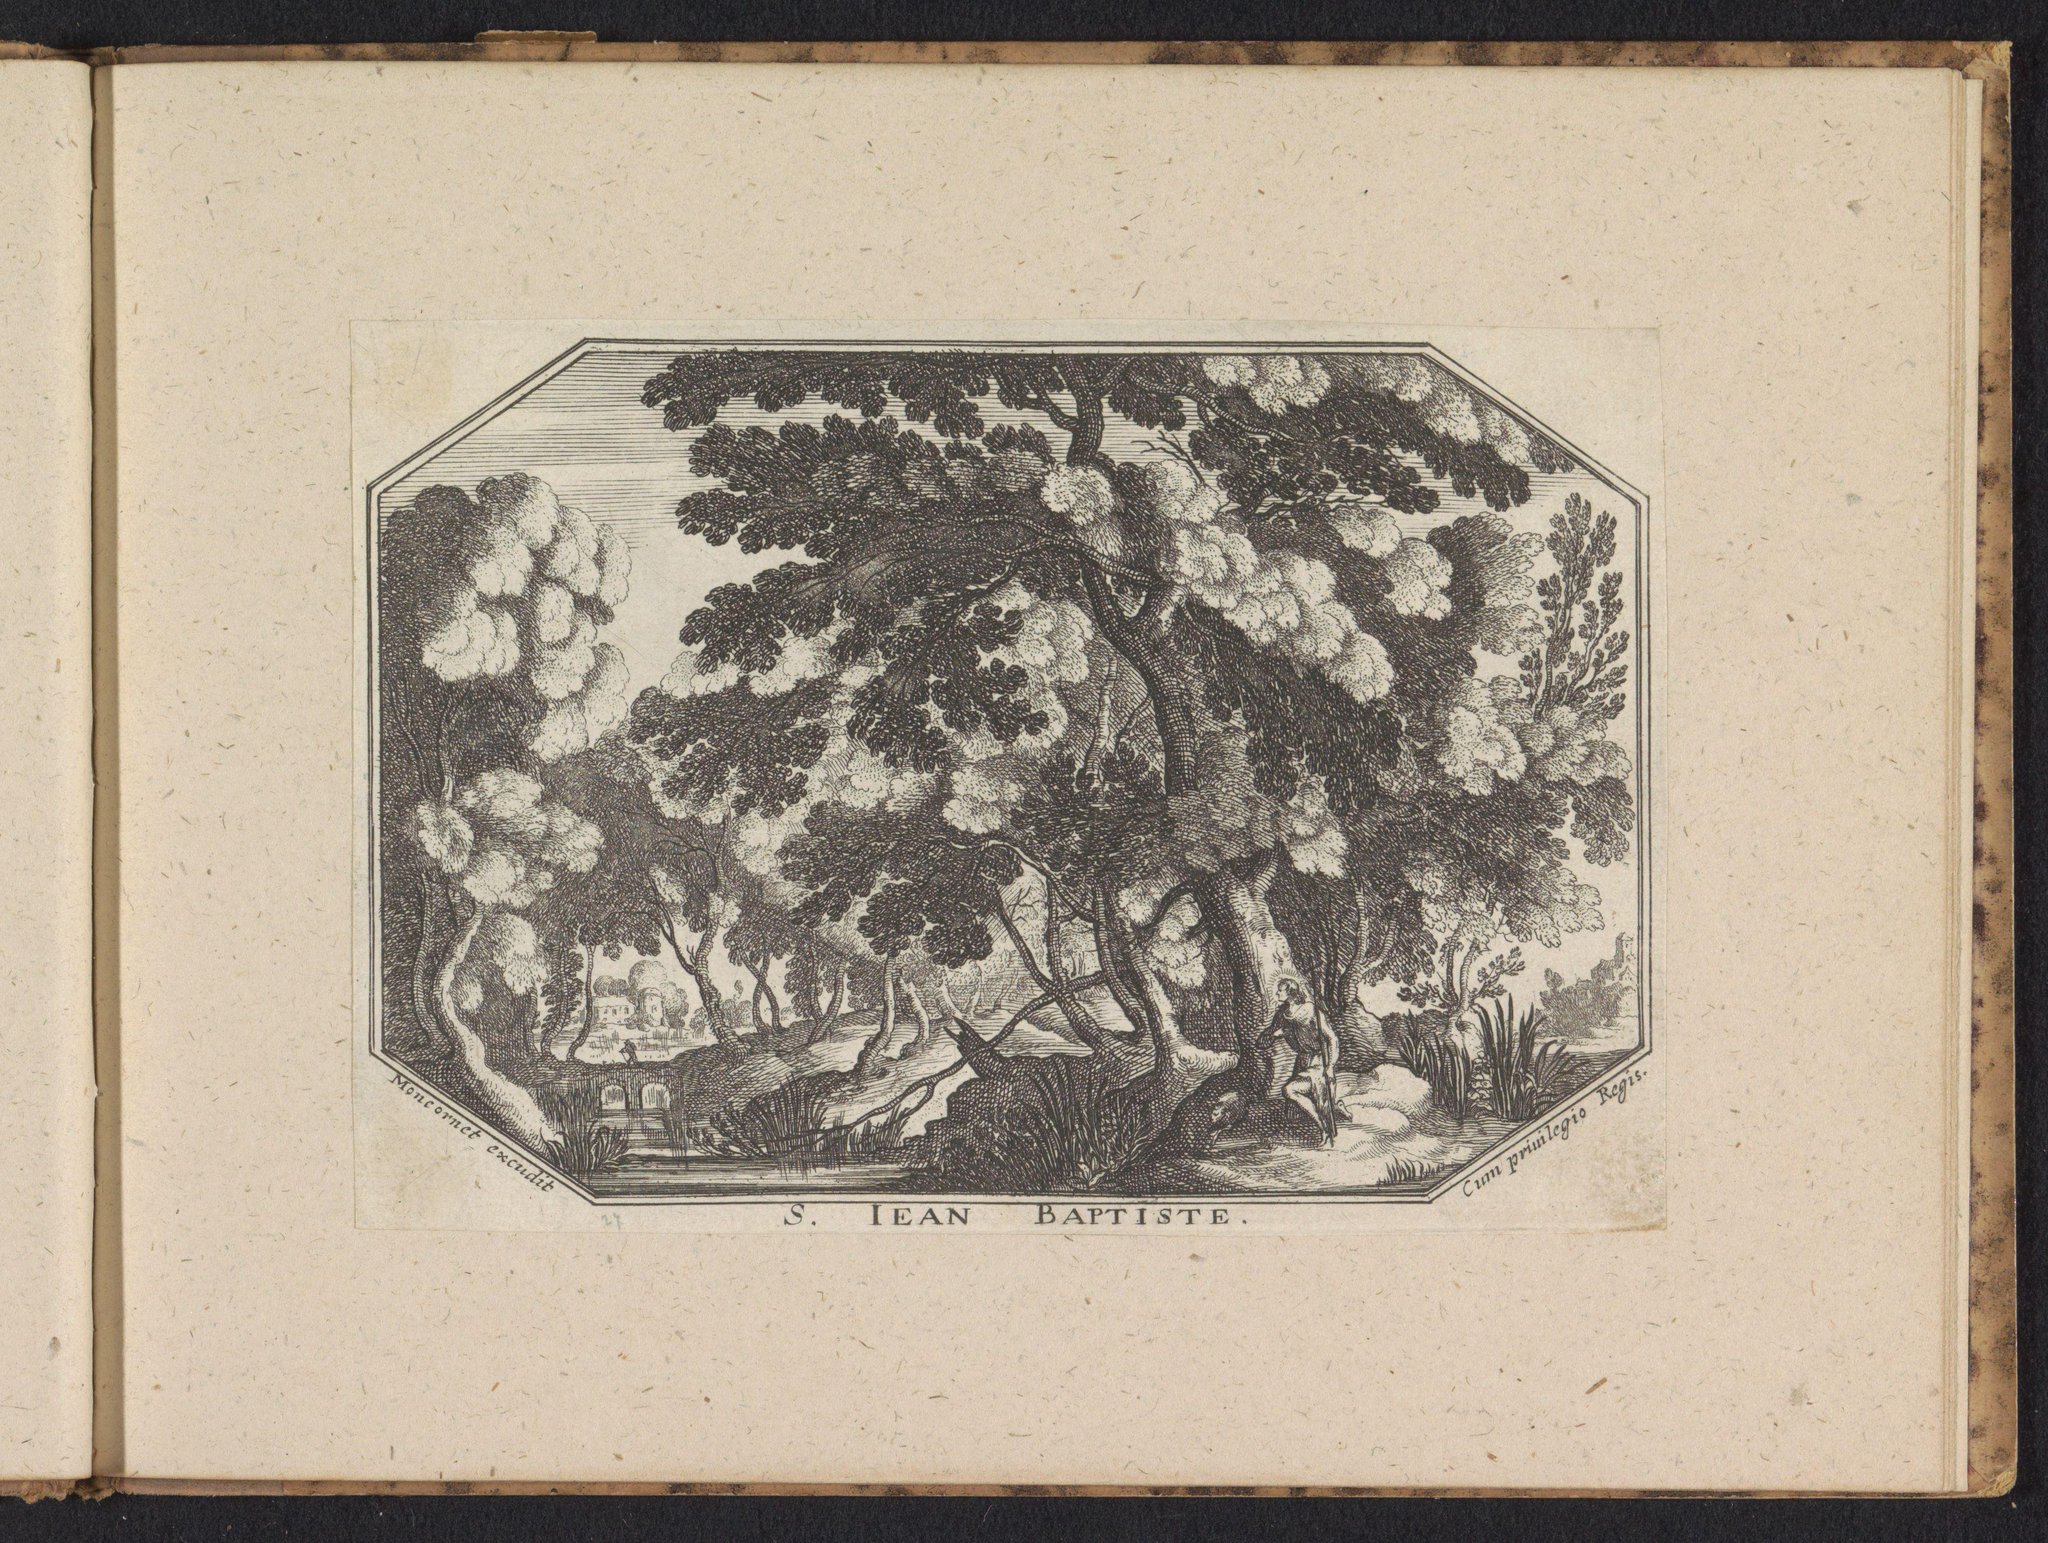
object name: print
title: Landschap met Johannes de Doper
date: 1600-1699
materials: paper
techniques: etching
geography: france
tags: landscapes, story of john the baptist (matthew 3; mark 1:4-11; luke 3:1-22; john 1:19-34)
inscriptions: collector's mark: Lugt 2228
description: Achthoekig boomrijk landschap met rechts Johannes de Doper. De prent maakt deel uit van een album.